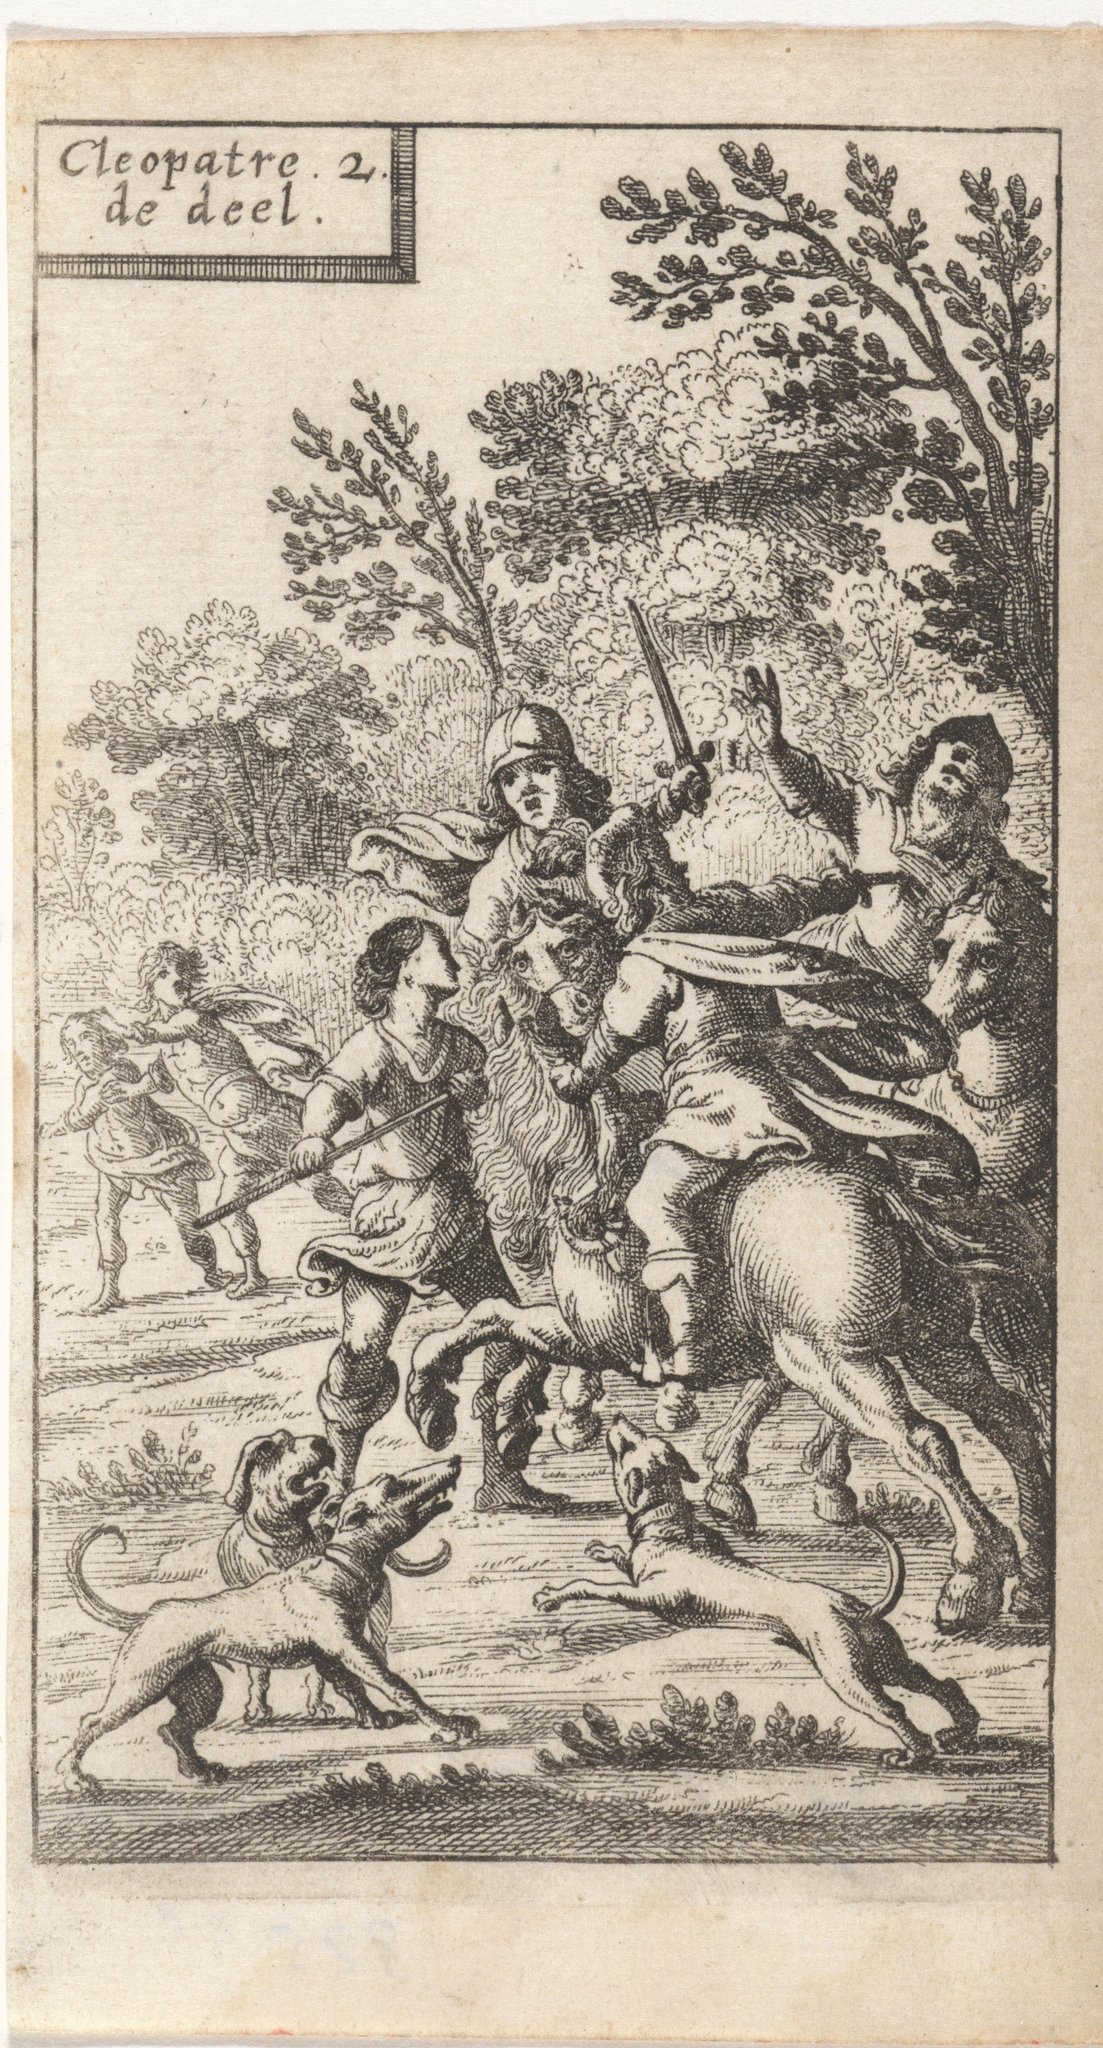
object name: print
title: Strijdende soldaten op twee galeien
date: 1667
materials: paper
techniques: etching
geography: netherlands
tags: drowning, shipwrecked person, battle (+ oared ships, e.g.: galley)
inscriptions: collector's mark: Lugt 2228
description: De prent is gebruikt als boekillustratie in: Calprenède, La. Cleopatre 3de deel..., Amsterdam: Gerrit van Goedesberg, 1667